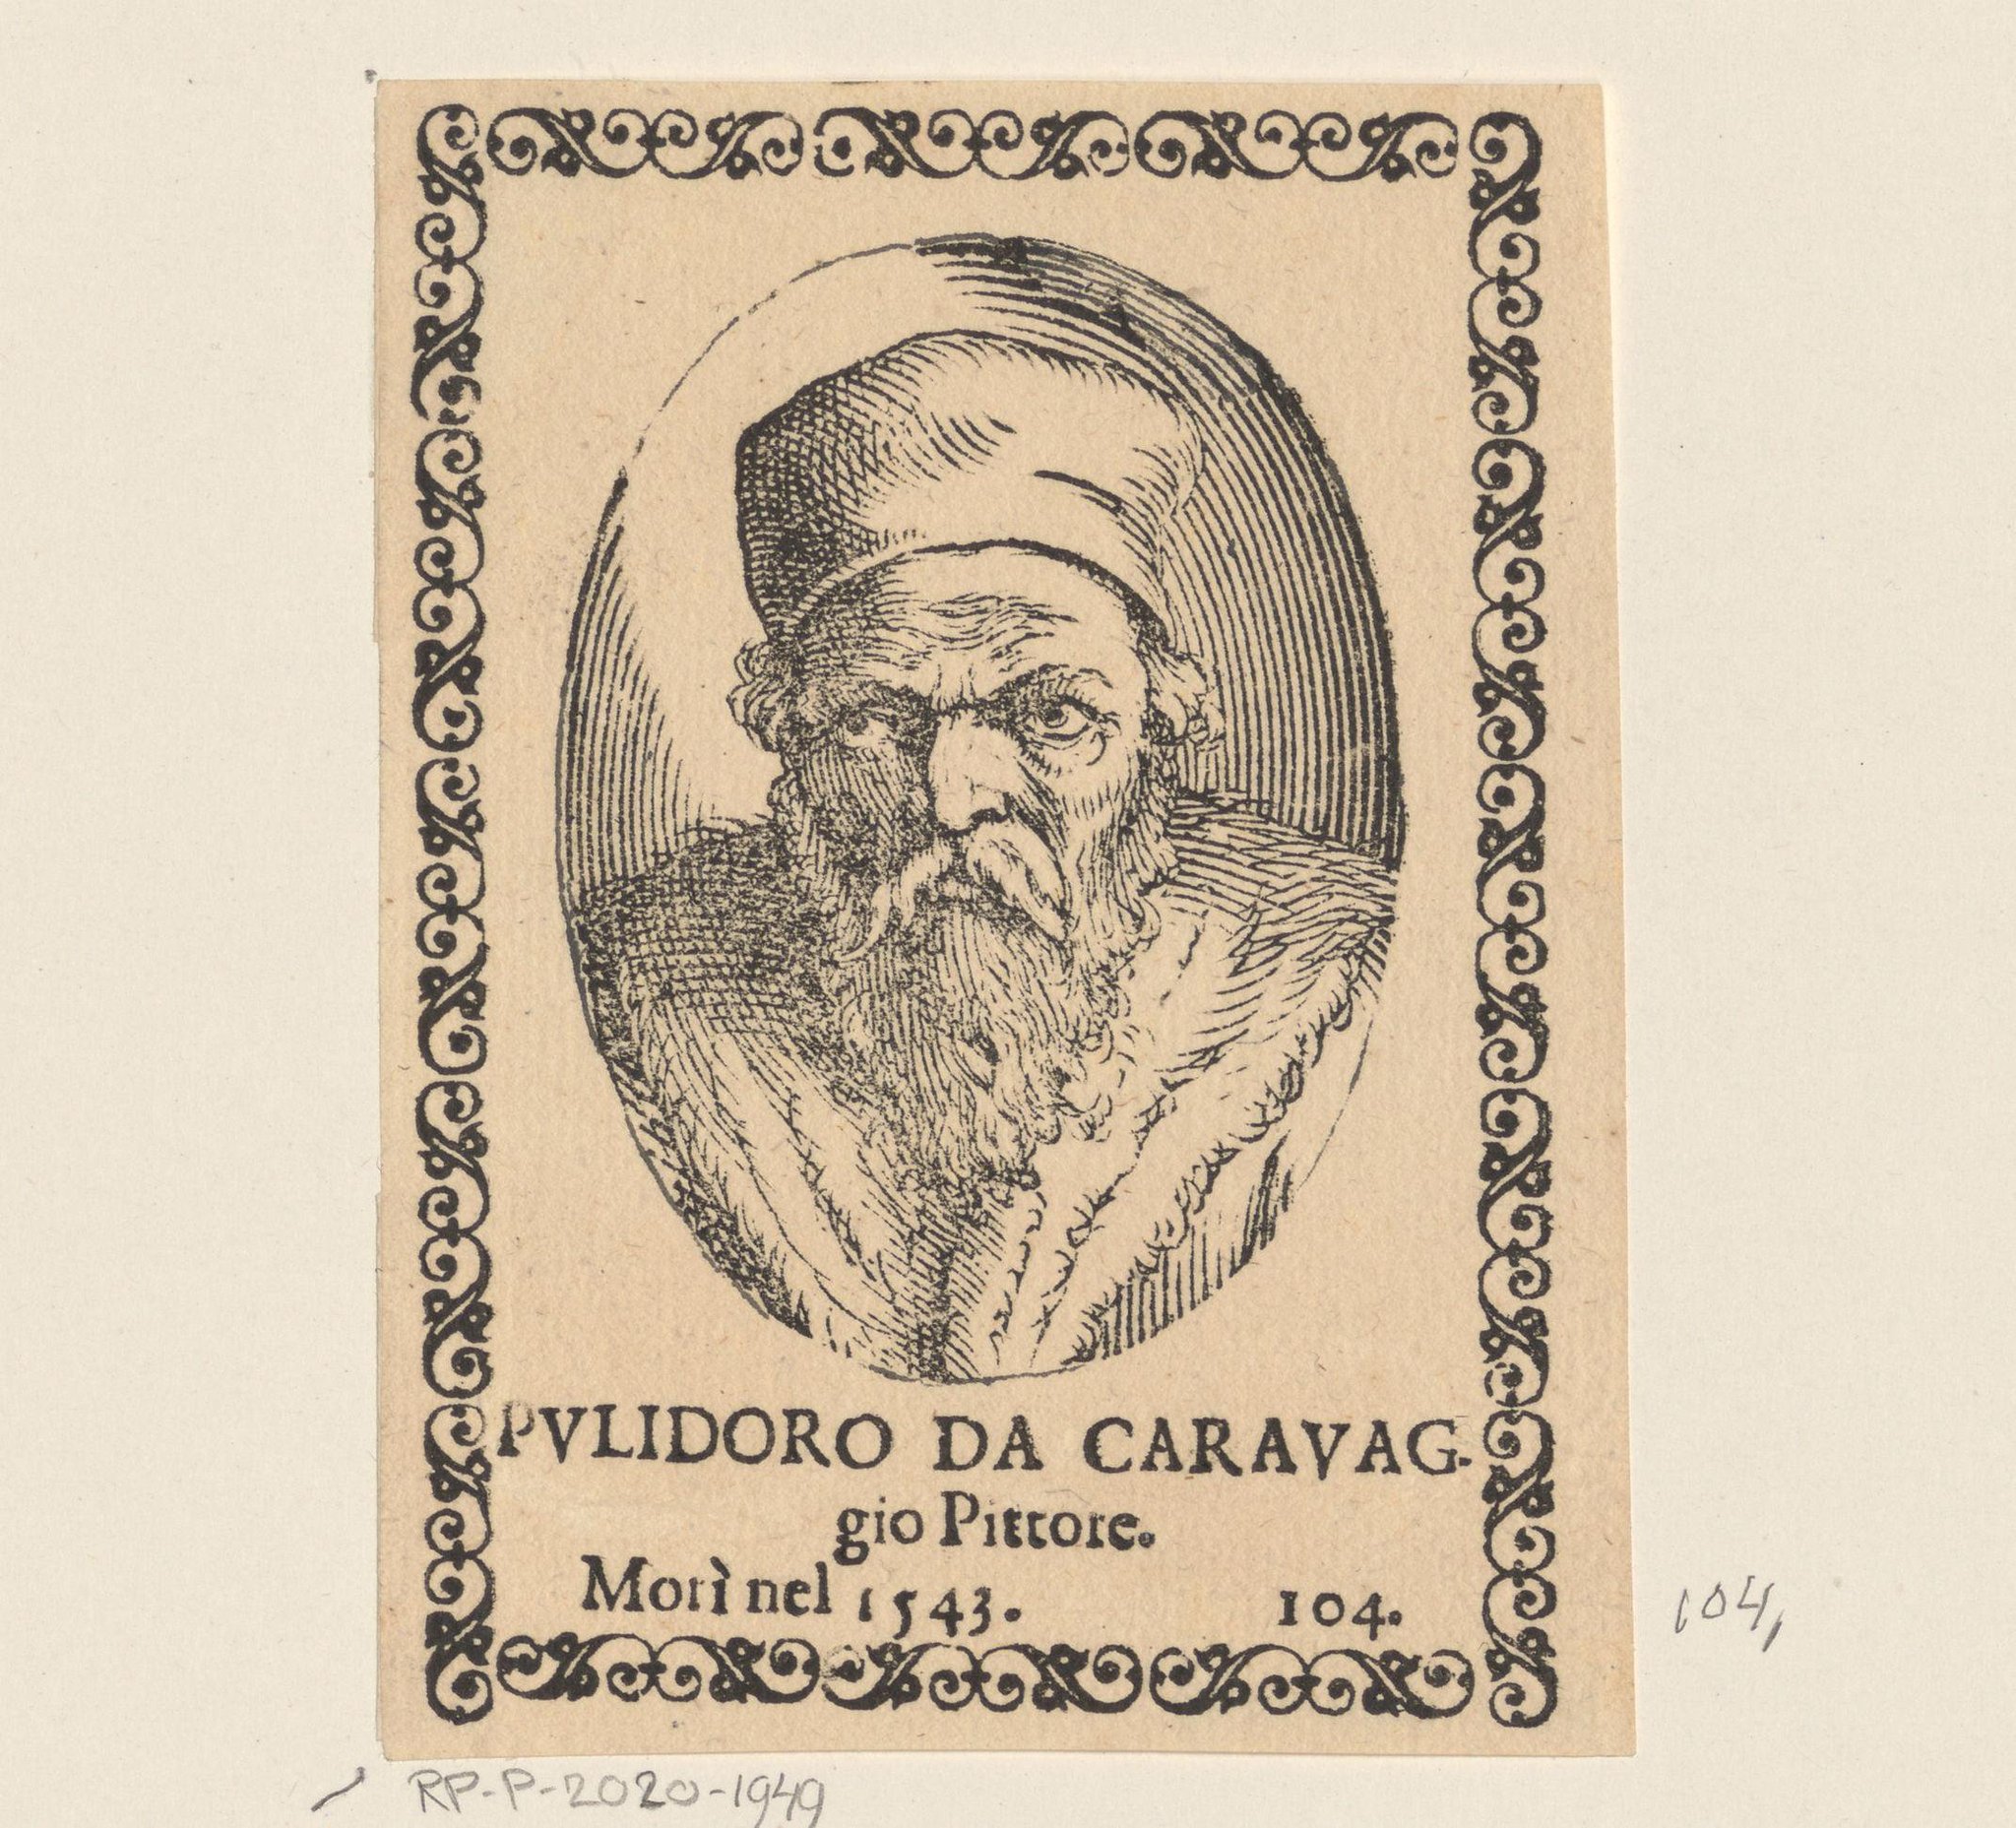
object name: print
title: Portret van Polidoro da Caravaggio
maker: Anonymous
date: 1586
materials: paper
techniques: woodcut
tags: polidoro da caravaggio, historical persons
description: Prent met andere omlijsting gebruikt in: Vasari, Giorgio. Le vite de’ più eccellenti pittori, scultori e architettori. Florence: Bernardo Giunti, 1586, dl. 3, p. 197.